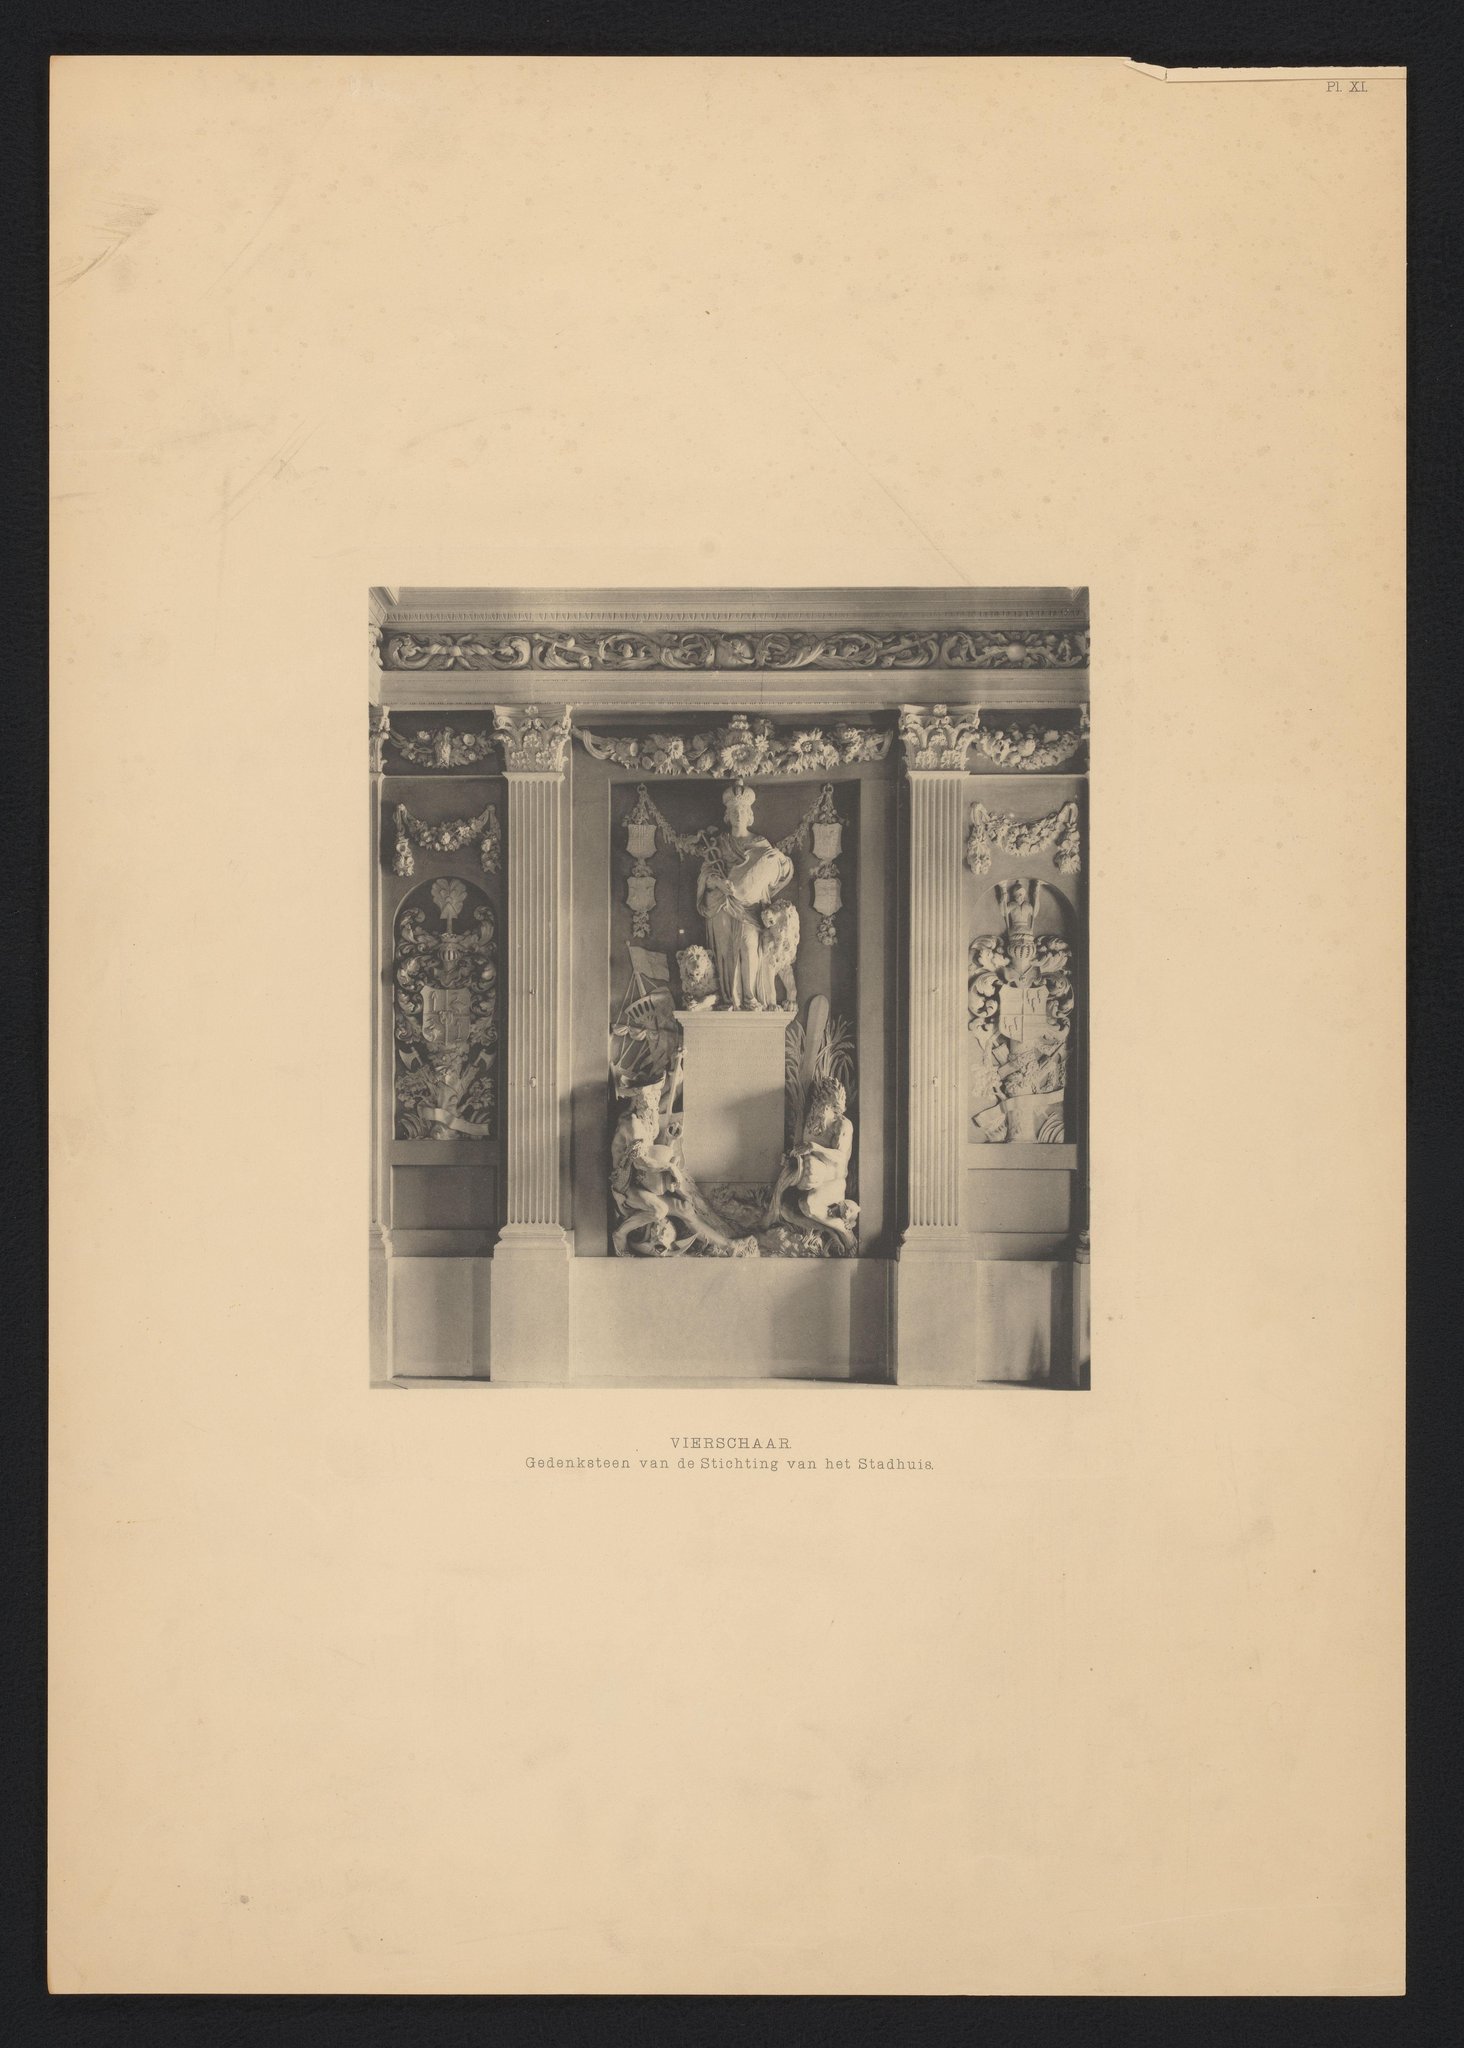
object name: photograph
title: Gedenksteen van de stichting van het Stadhuis, Vierschaar, Paleis op de Dam, Amsterdam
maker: Anonymous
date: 1899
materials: cardboard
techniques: photograph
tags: palace, piece of sculpture, reproduction of a piece of sculpture, royal palace of amsterdam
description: Vierschaar. Gedenksteen van de Stichting van het Stadhuis.